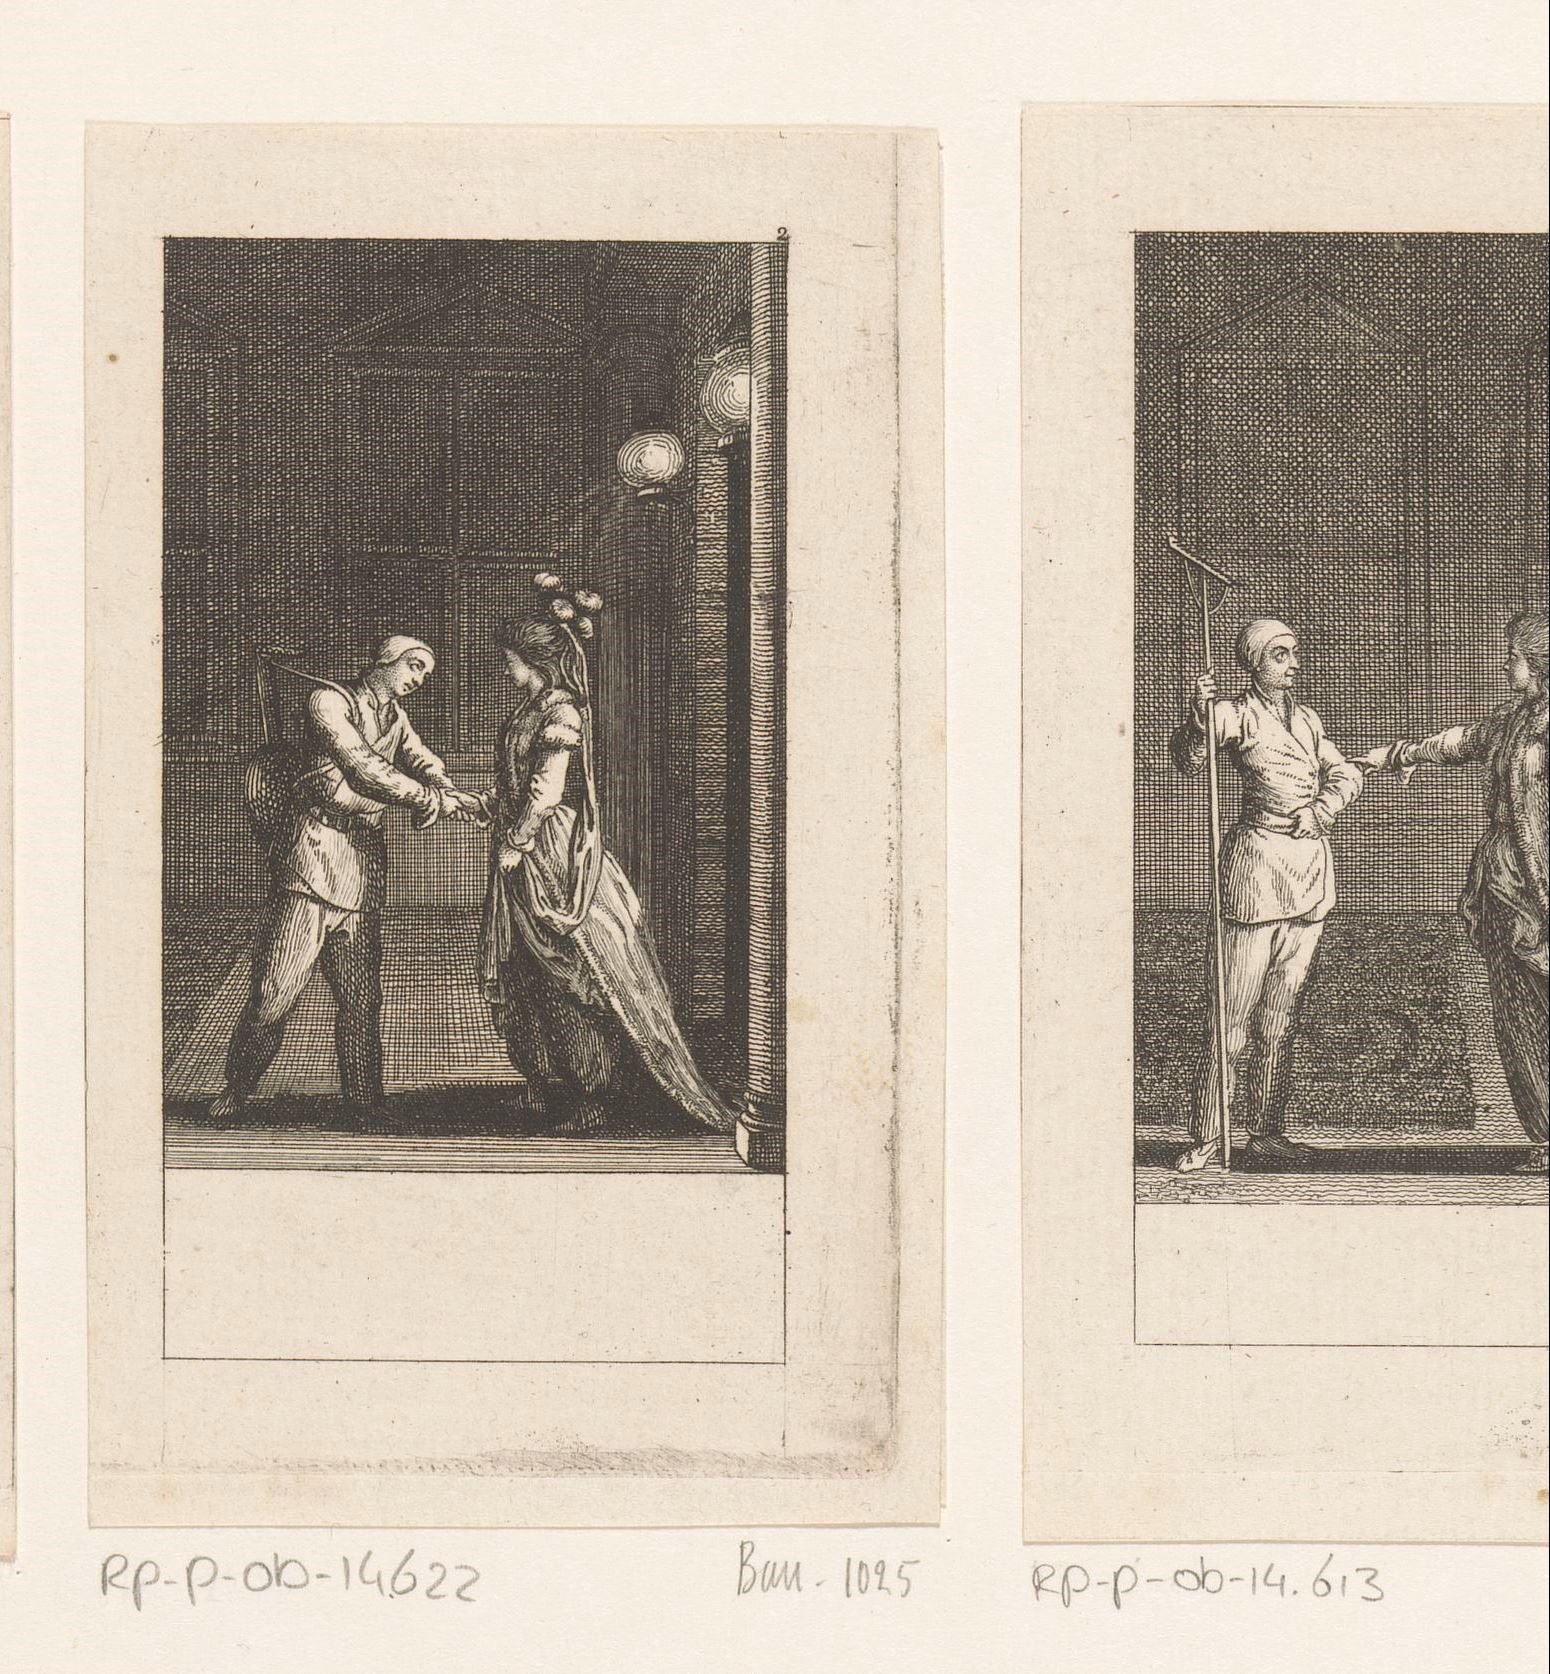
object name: print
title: Adelheid spreekt met Osman, wie eigenlijk haar tot slaaf gemaakte verloofde Karl blijkt te zijn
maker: daniel nikolaus chodowiecki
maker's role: draughtsman, print maker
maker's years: 1726-1801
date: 1783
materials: paper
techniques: etching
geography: berlin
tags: berlin, literature, slavery; serfs and enslaved persons, lighting; lamps, lovers' meeting, lute, and special forms of lute, e.g.: theorbo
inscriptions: collector's mark: Lugt 2228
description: Vervaardigd voor G. F. W. Grossmann's 'Adelheid von Veltheim'. Een latere staat gebruikt in: Königlich Grosbritannischer genealogischer Kalender auf das Jahr 1784. Lauenburg: Berenberg, 1783.